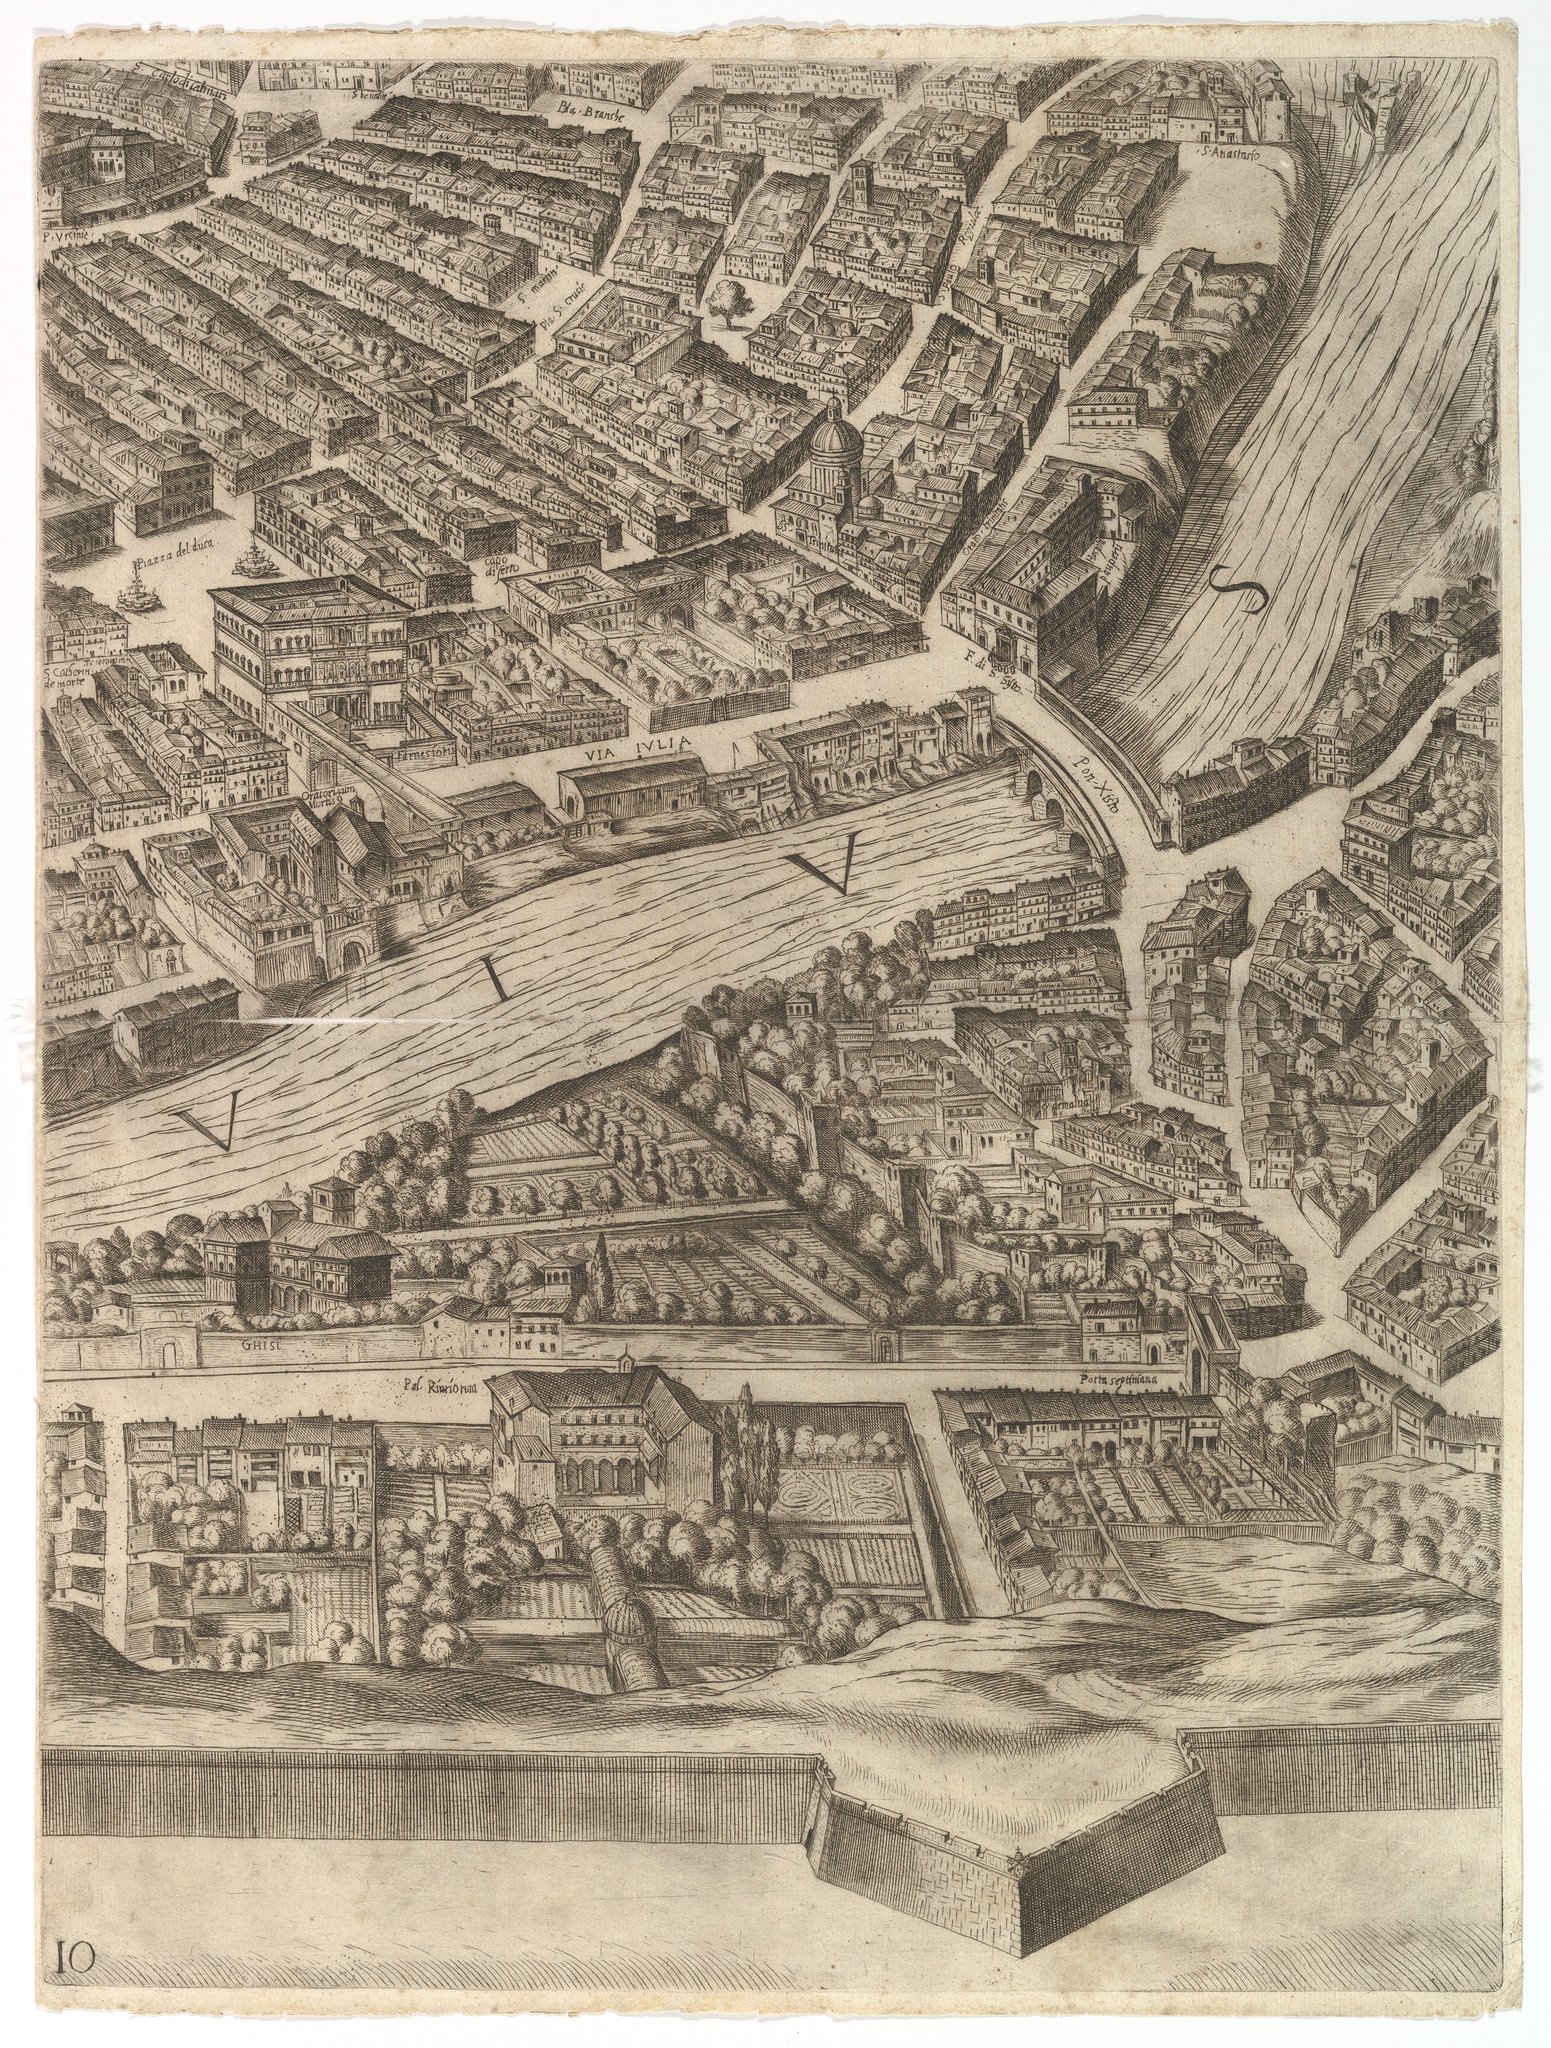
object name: print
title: Plan of the City of Rome. Part 10 with the Tiber and the Villa Farnesina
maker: antonio tempesta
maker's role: artist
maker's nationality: italian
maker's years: 1555-1630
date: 1645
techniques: engraving, etching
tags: cities,rivers,rome